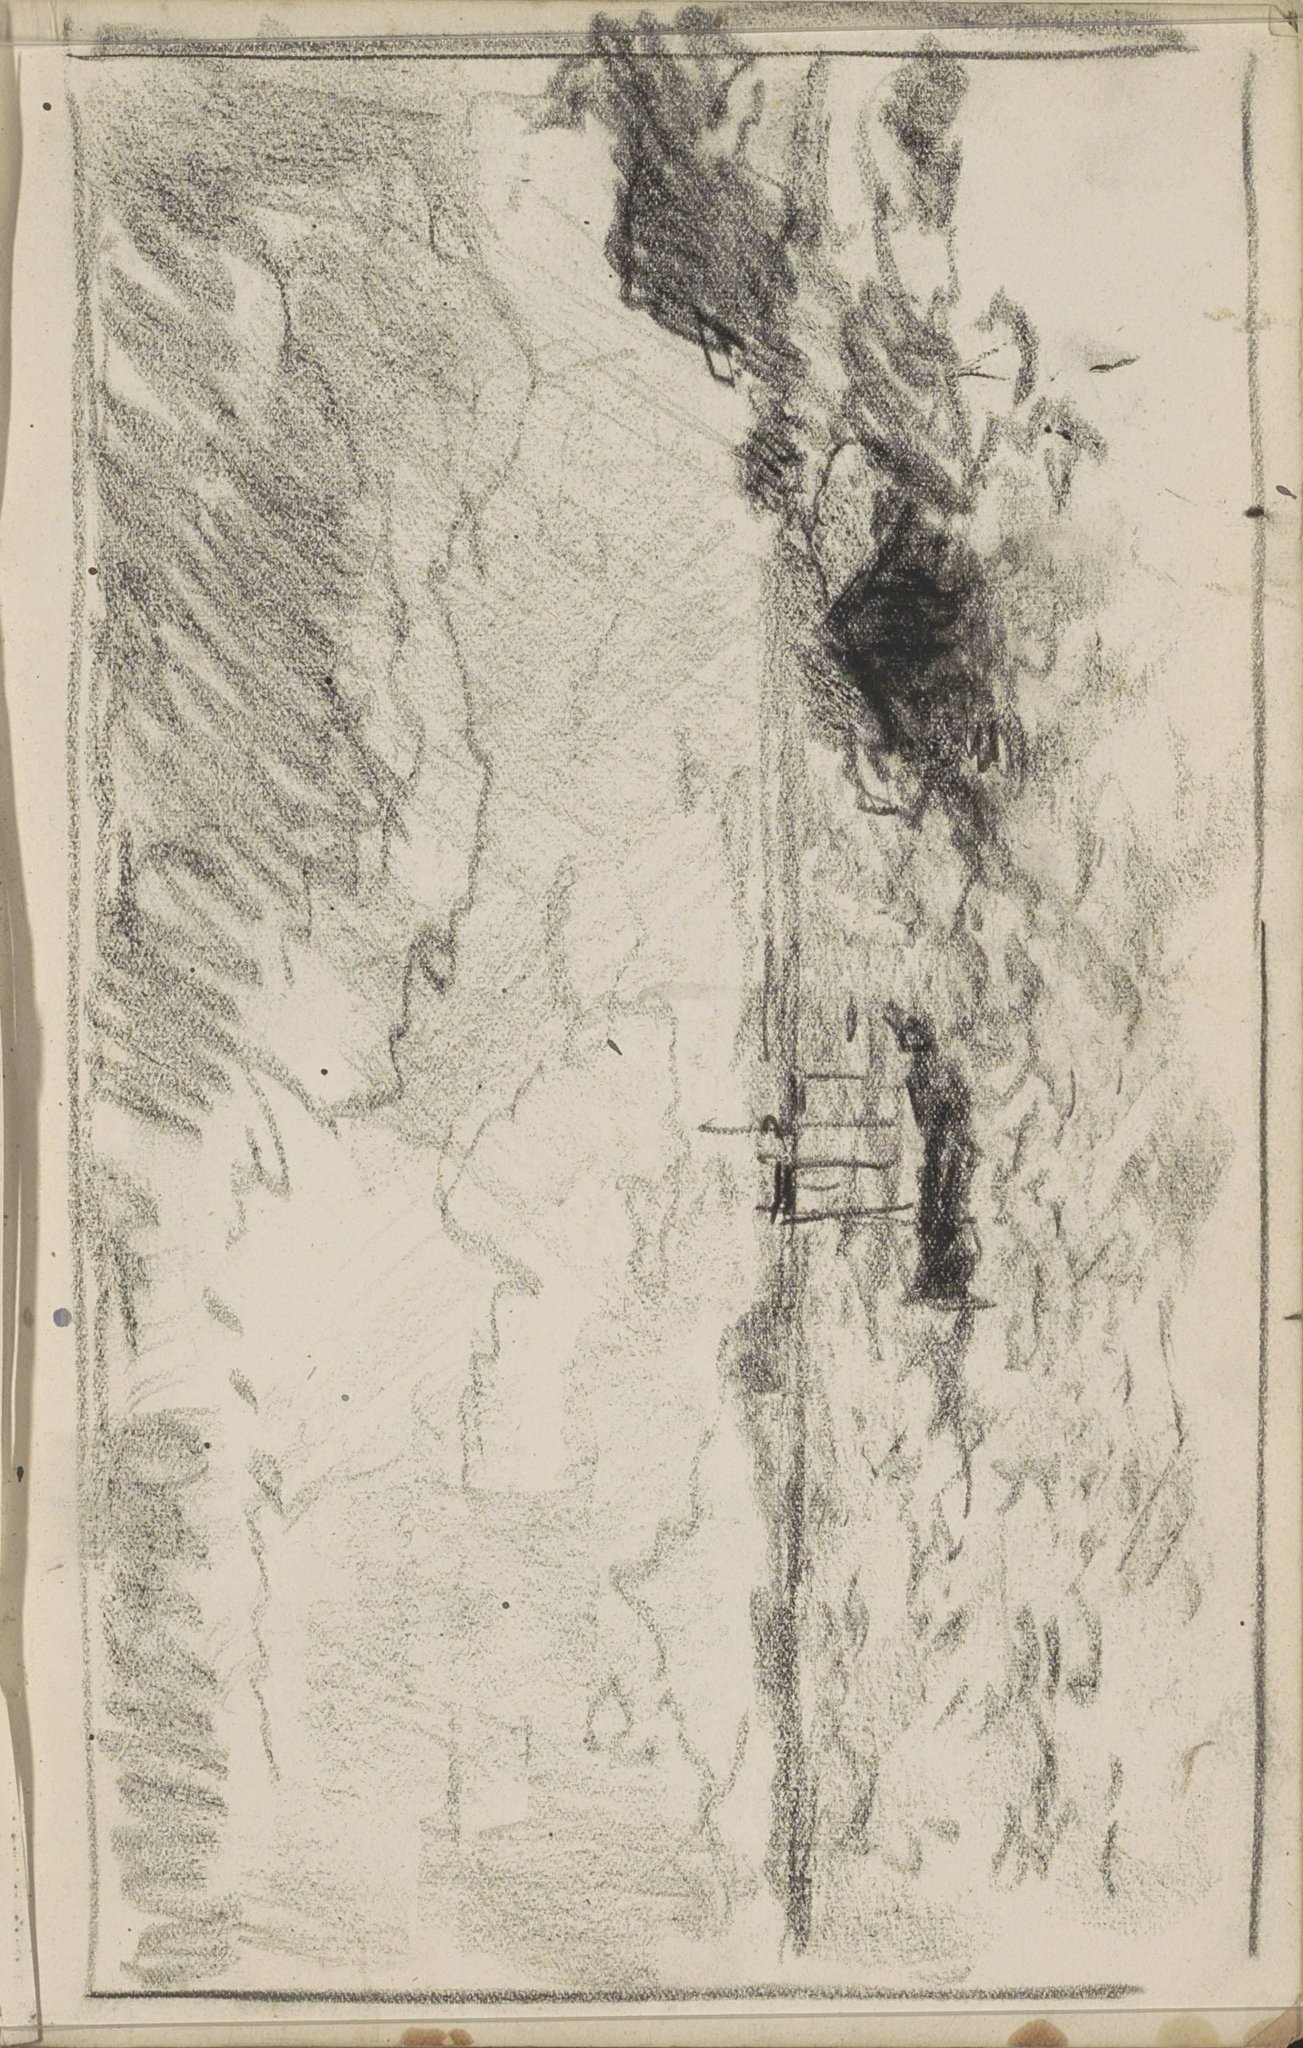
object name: sketchbook leaf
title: Boot bij een klif op een stormachtige zee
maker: cornelis vreedenburgh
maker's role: draughtsman, print maker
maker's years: 1880-1946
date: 1890-1946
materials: chalk, paper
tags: coastal cliff or crag, sea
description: Blad 11 recto uit een schetsboek met 45 bladen.